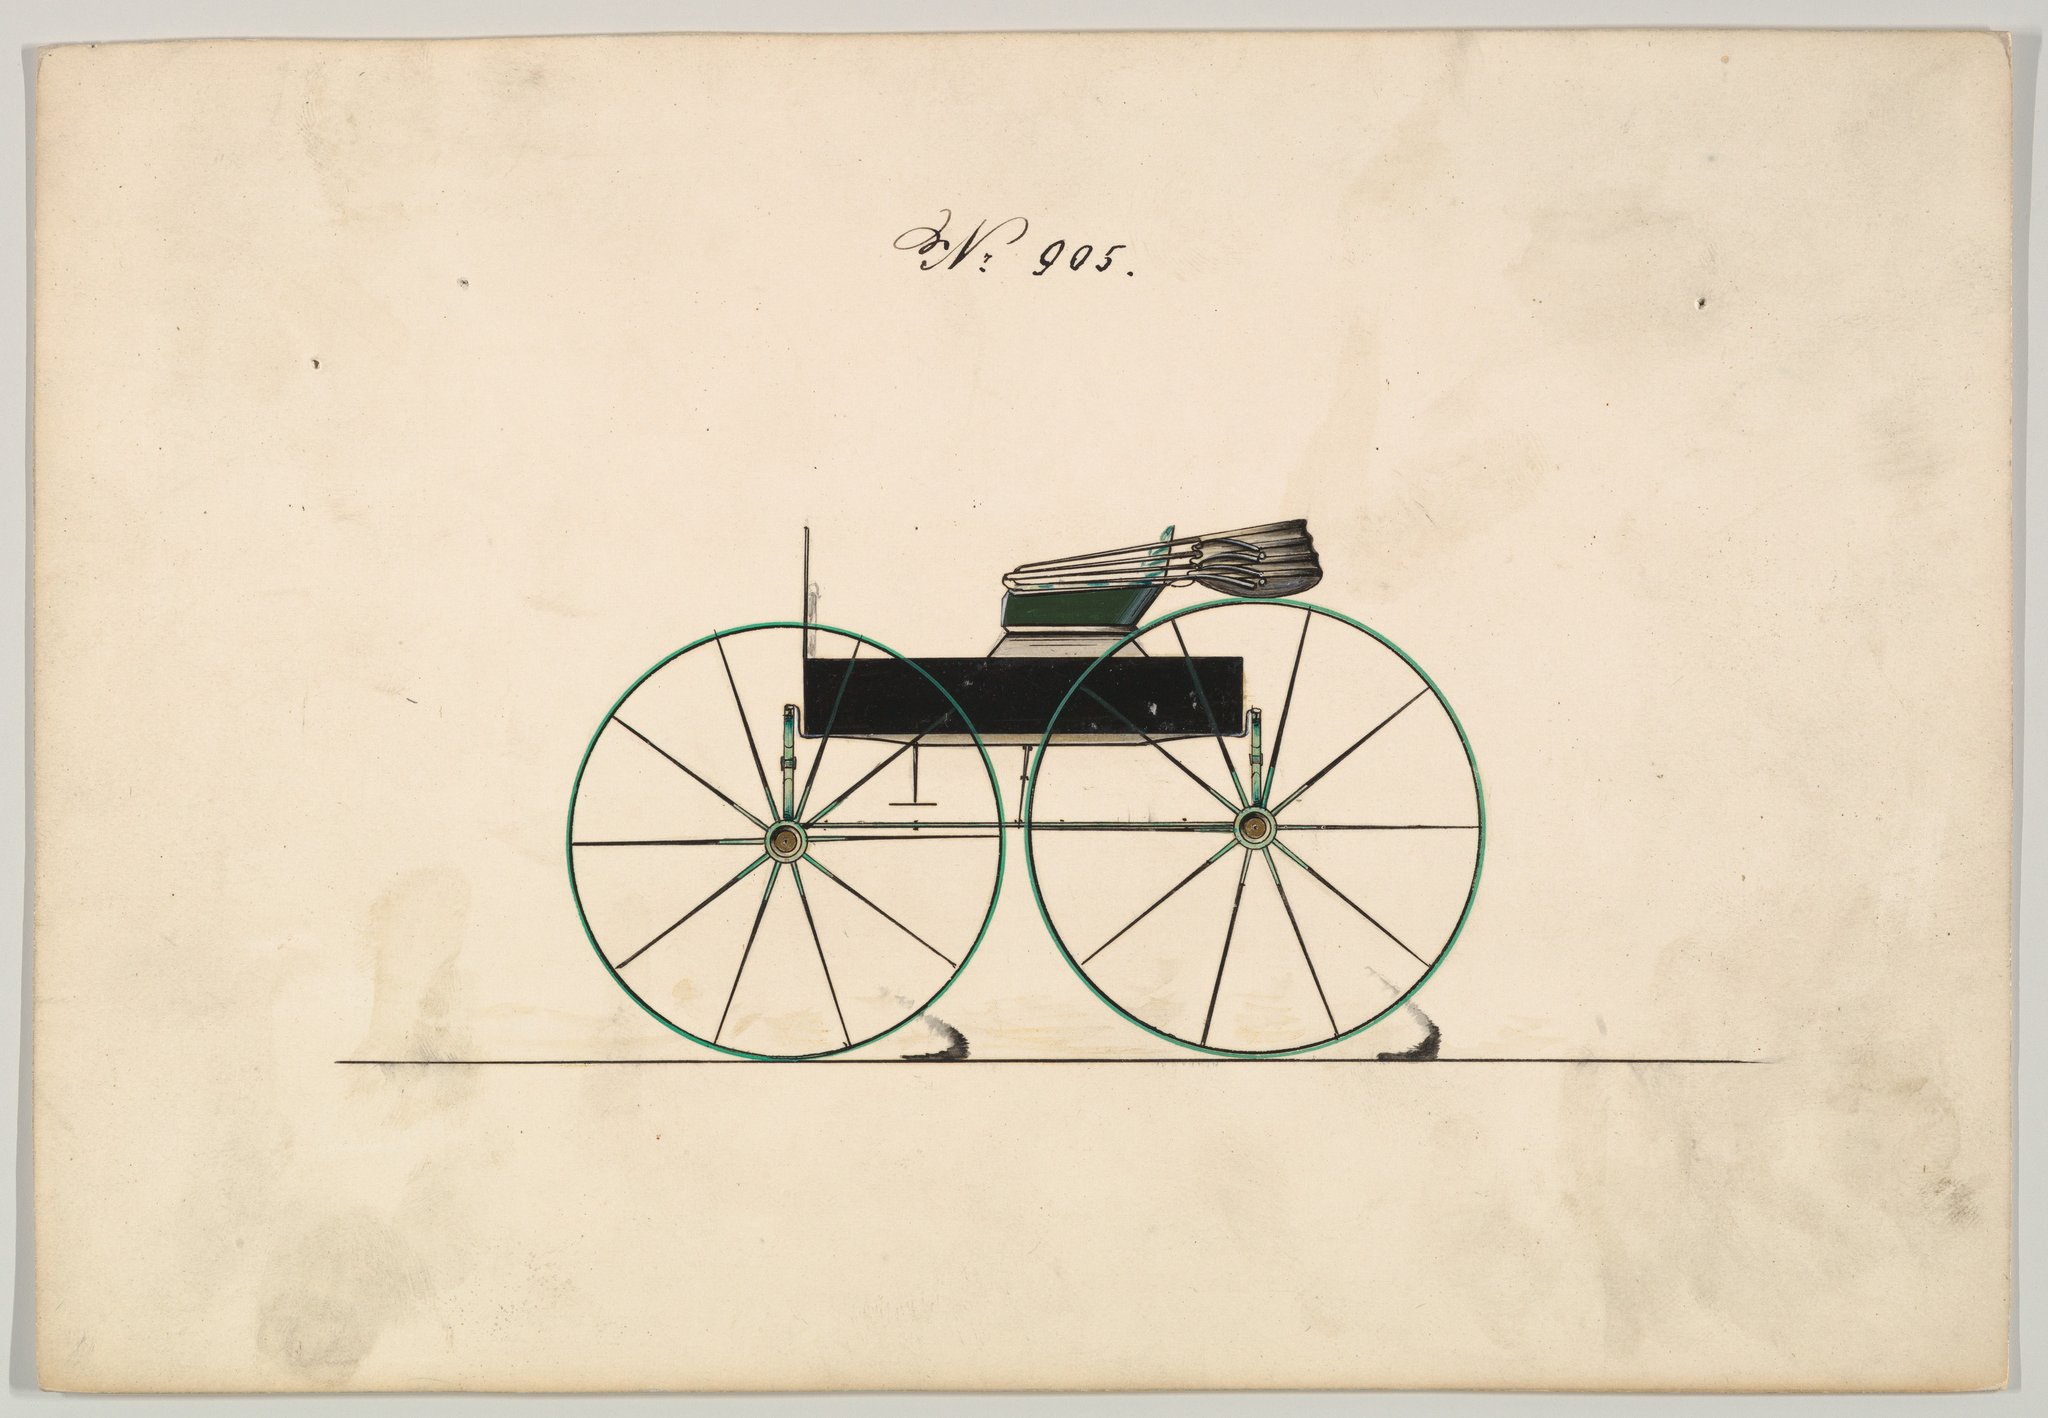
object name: drawing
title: Design for Wagon, no. 905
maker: brewster & co.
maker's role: manufacturer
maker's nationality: american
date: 1860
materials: gouache, gum arabic, ink, watercolor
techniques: pen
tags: carriages